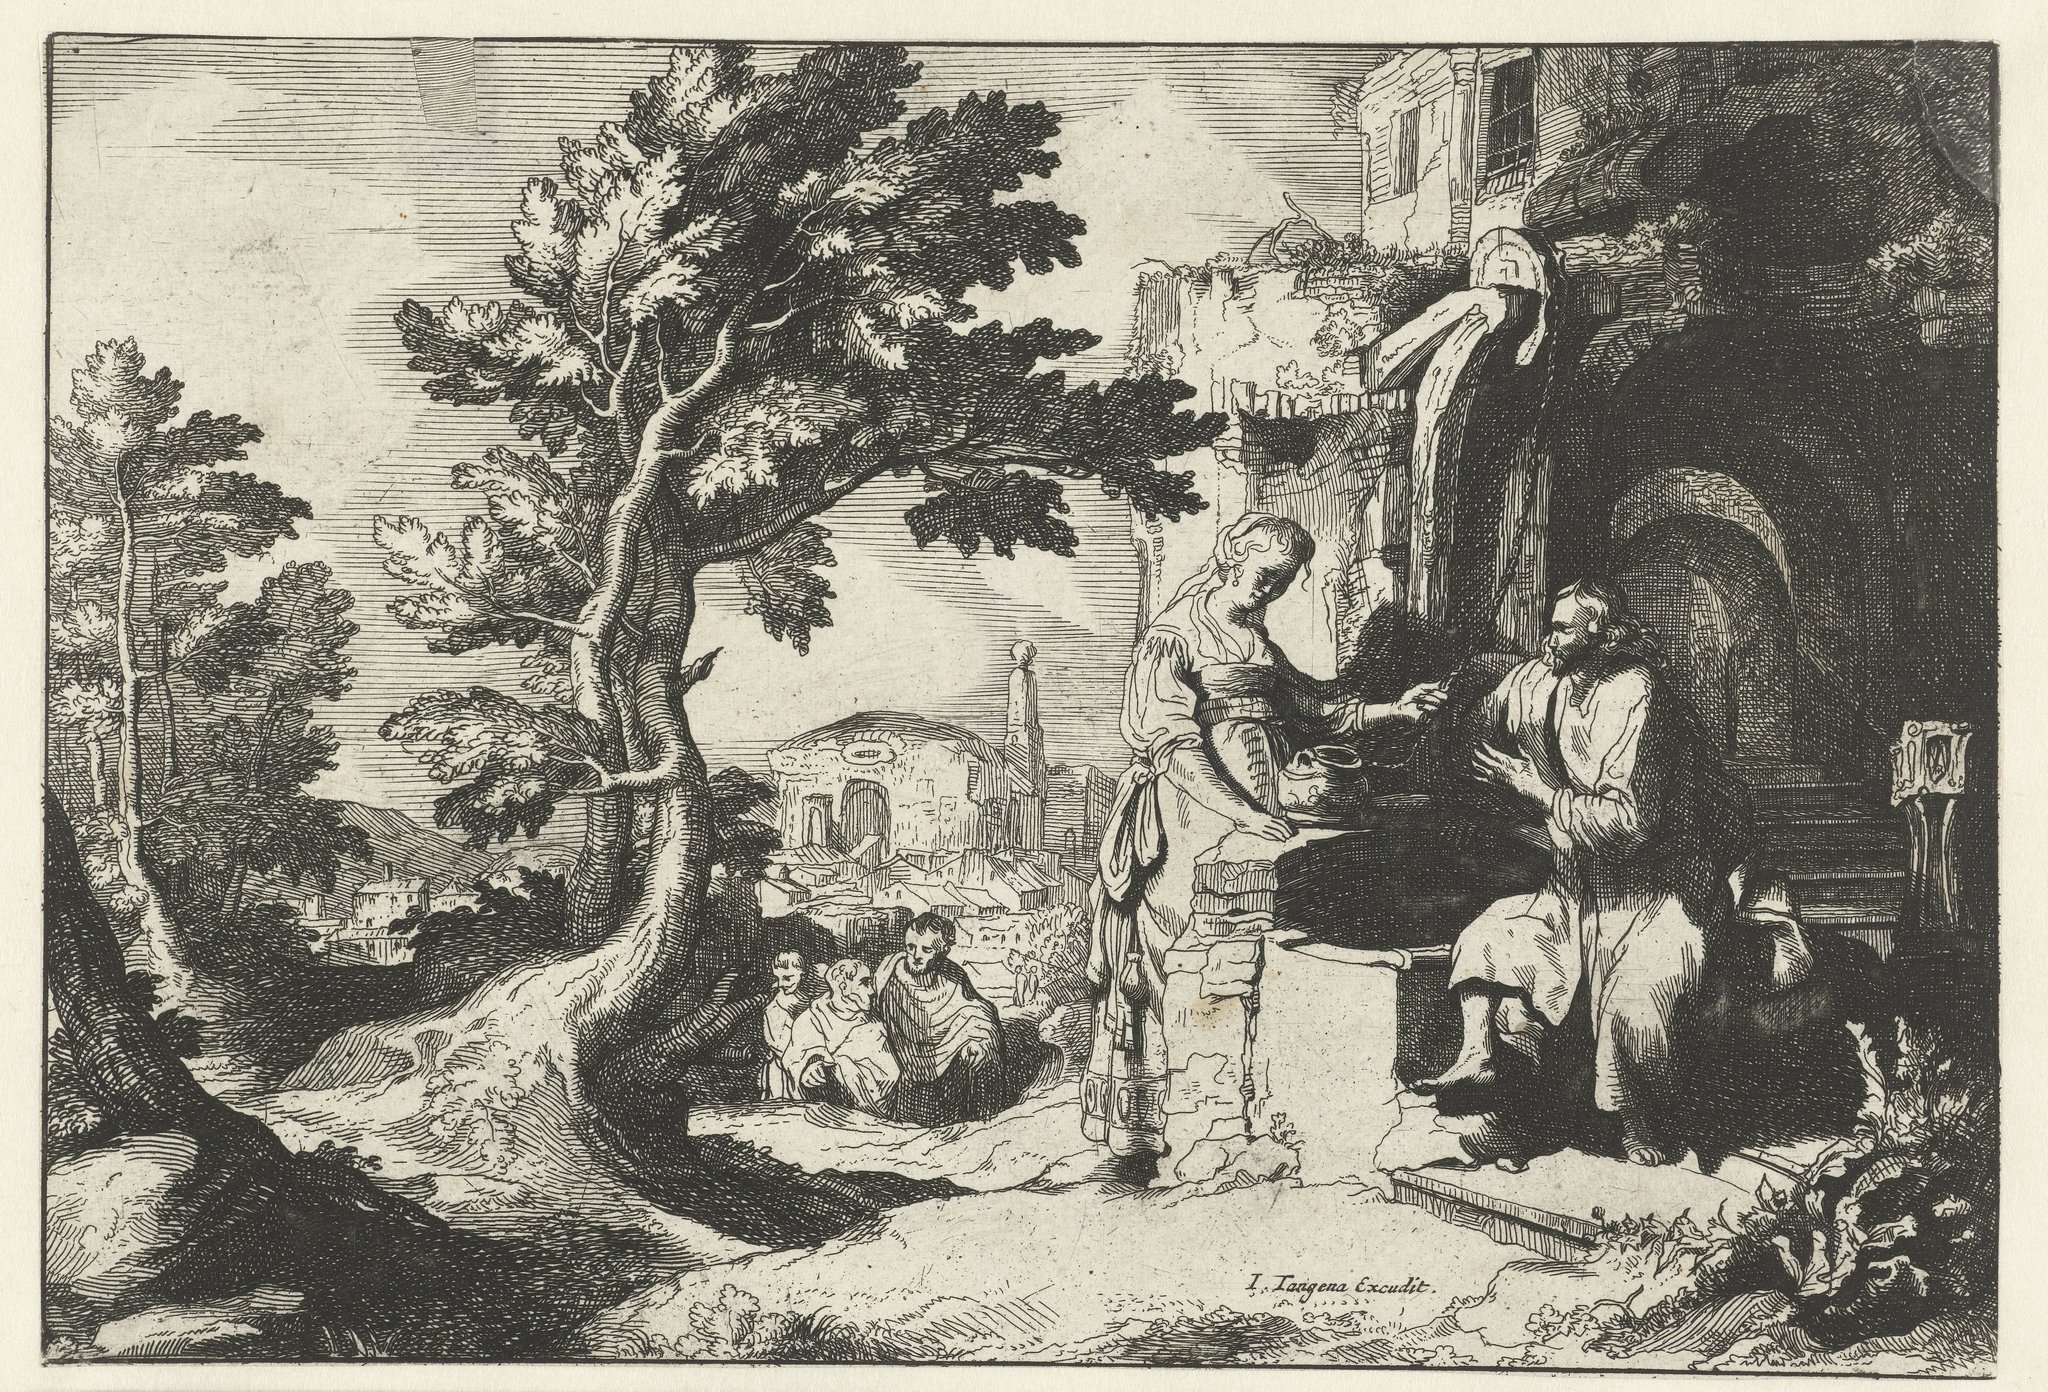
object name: print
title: Christ and the woman of Samaria among ruins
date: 1634-1690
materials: paper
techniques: etching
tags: christ and the woman of samaria: sitting at jacob's well he asks her for a drink from her jug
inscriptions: collector's mark: Lugt 240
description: Spiegelbeeldige kopie naar de gelijknamige prent van Rembrandt.